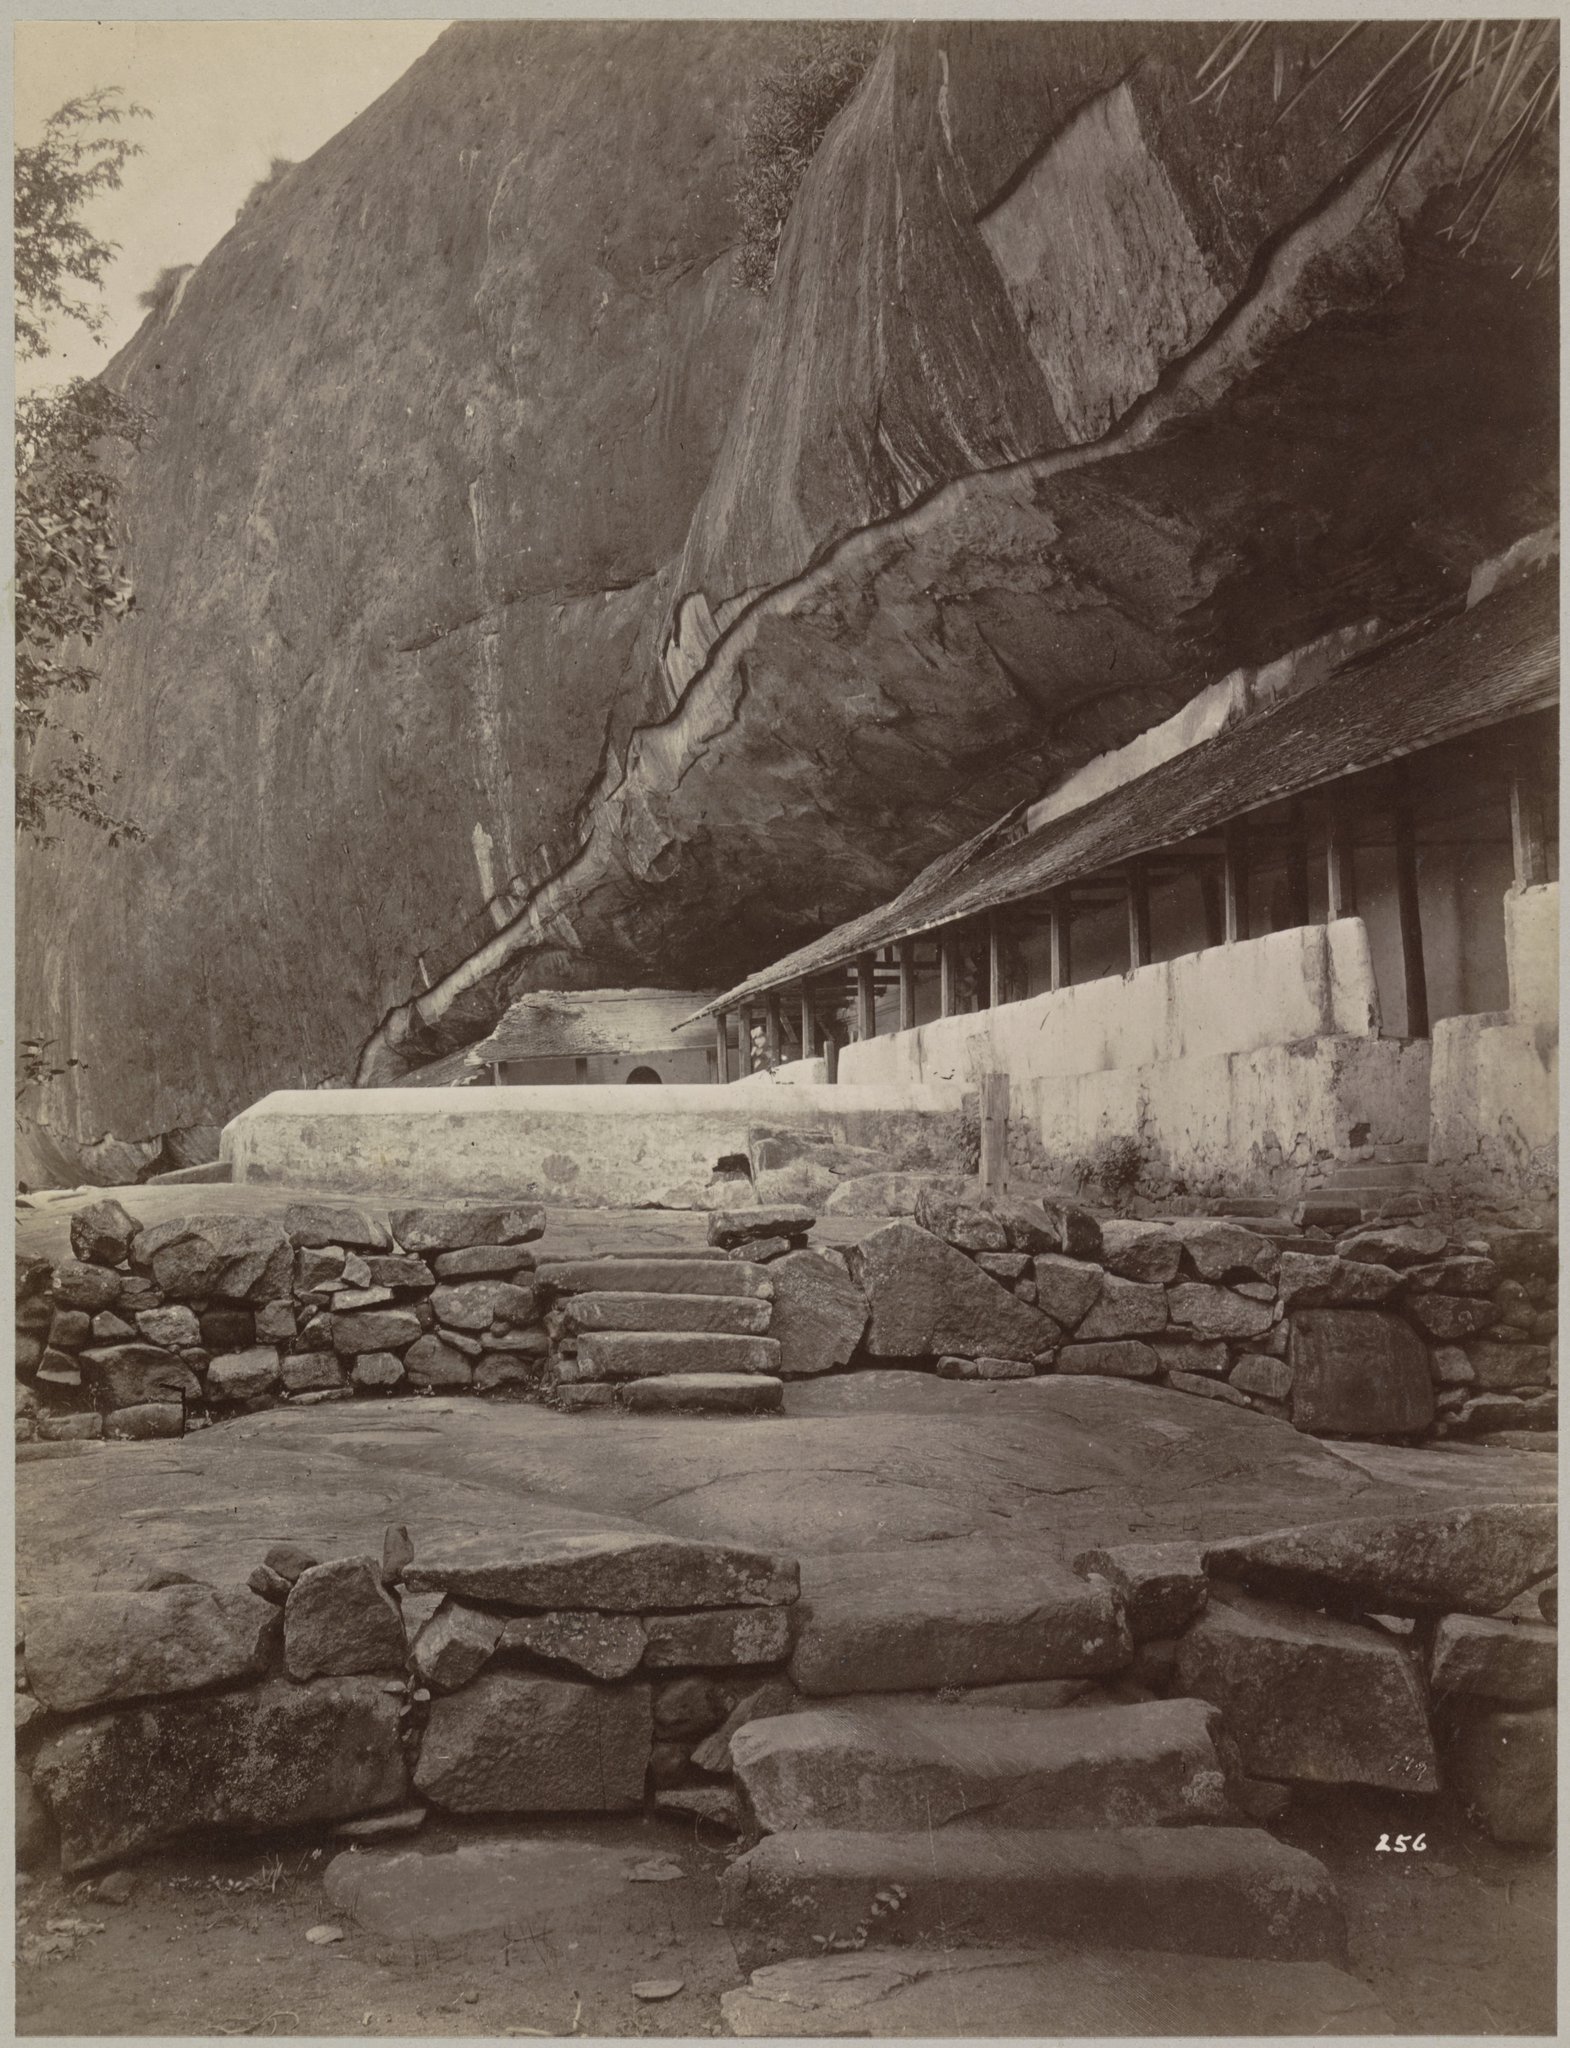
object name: photograph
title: Cave Temple of Dambulla, Sri Lanka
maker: Anonymous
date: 1895-1915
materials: cardboard, paper, photographic support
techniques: albumen print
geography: dambulla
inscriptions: number: ‘256’, inscription: ‘5. Dambulla.’